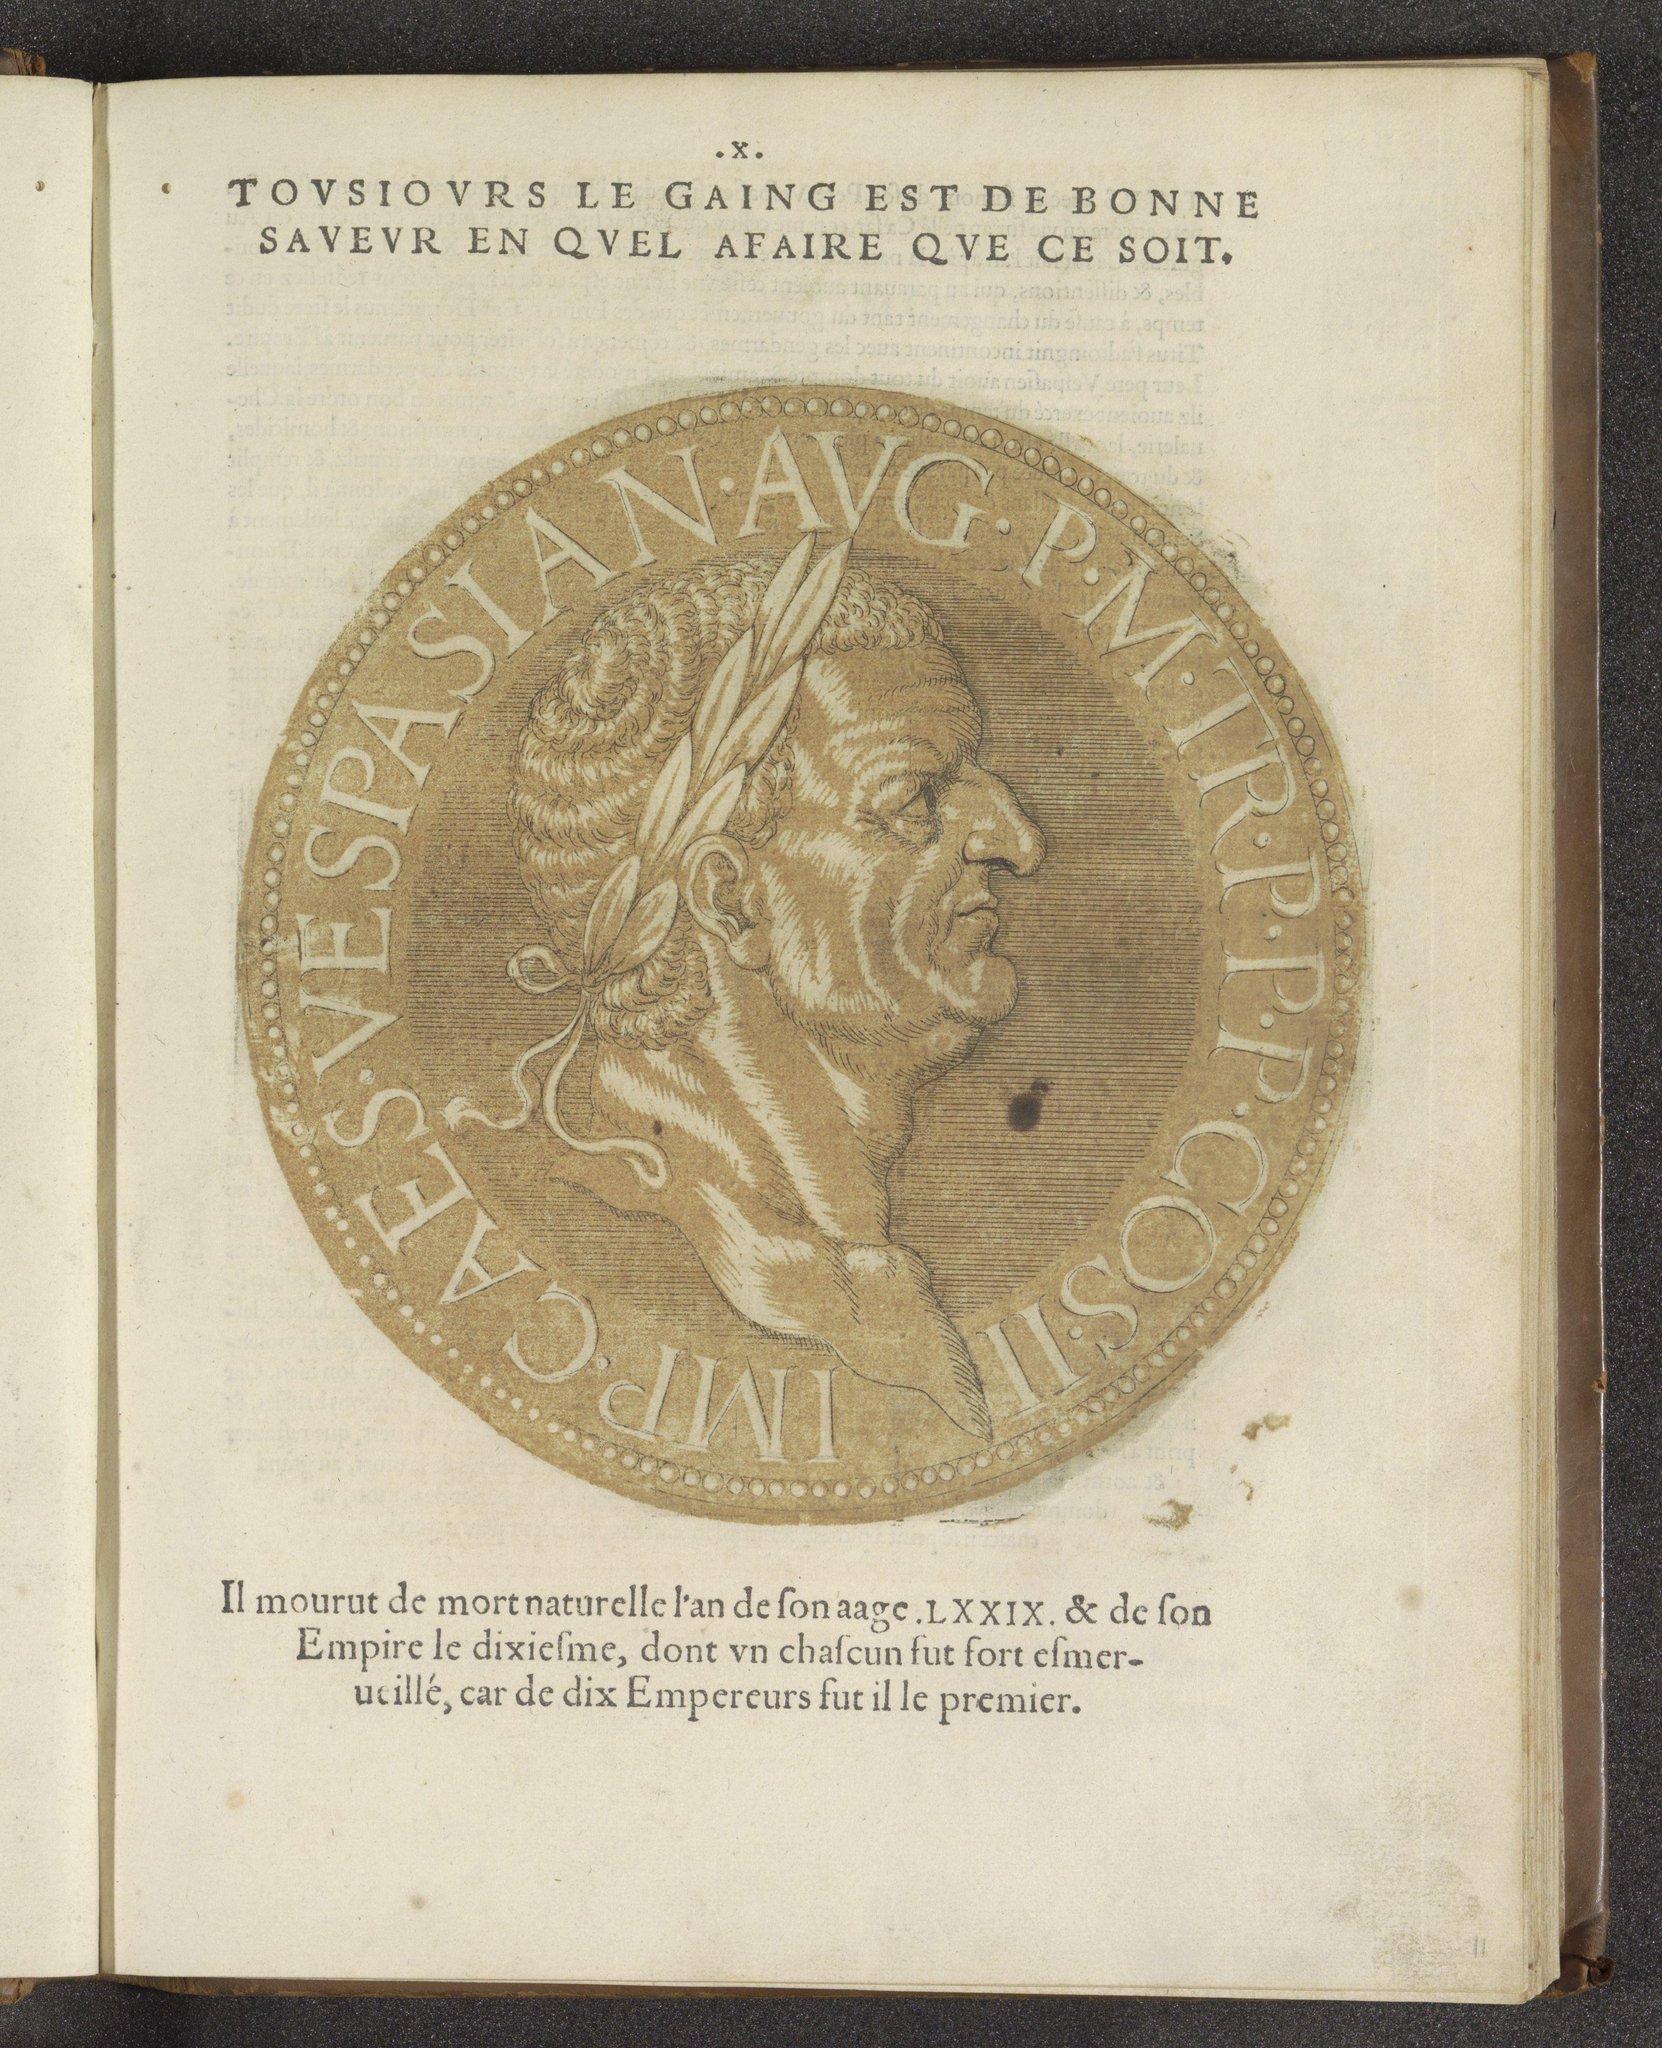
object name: page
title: Les images presque de tous les empereurs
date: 1557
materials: paper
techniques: woodcut, etching, letterpress printing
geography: antwerp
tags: emperor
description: Portret van keizer Vespasianus, op een munt met randschrift. De prent maakt deel uit van een boek over de keizers vanaf Julius Caesar tot en met Karel V en zijn broer Ferdinand.